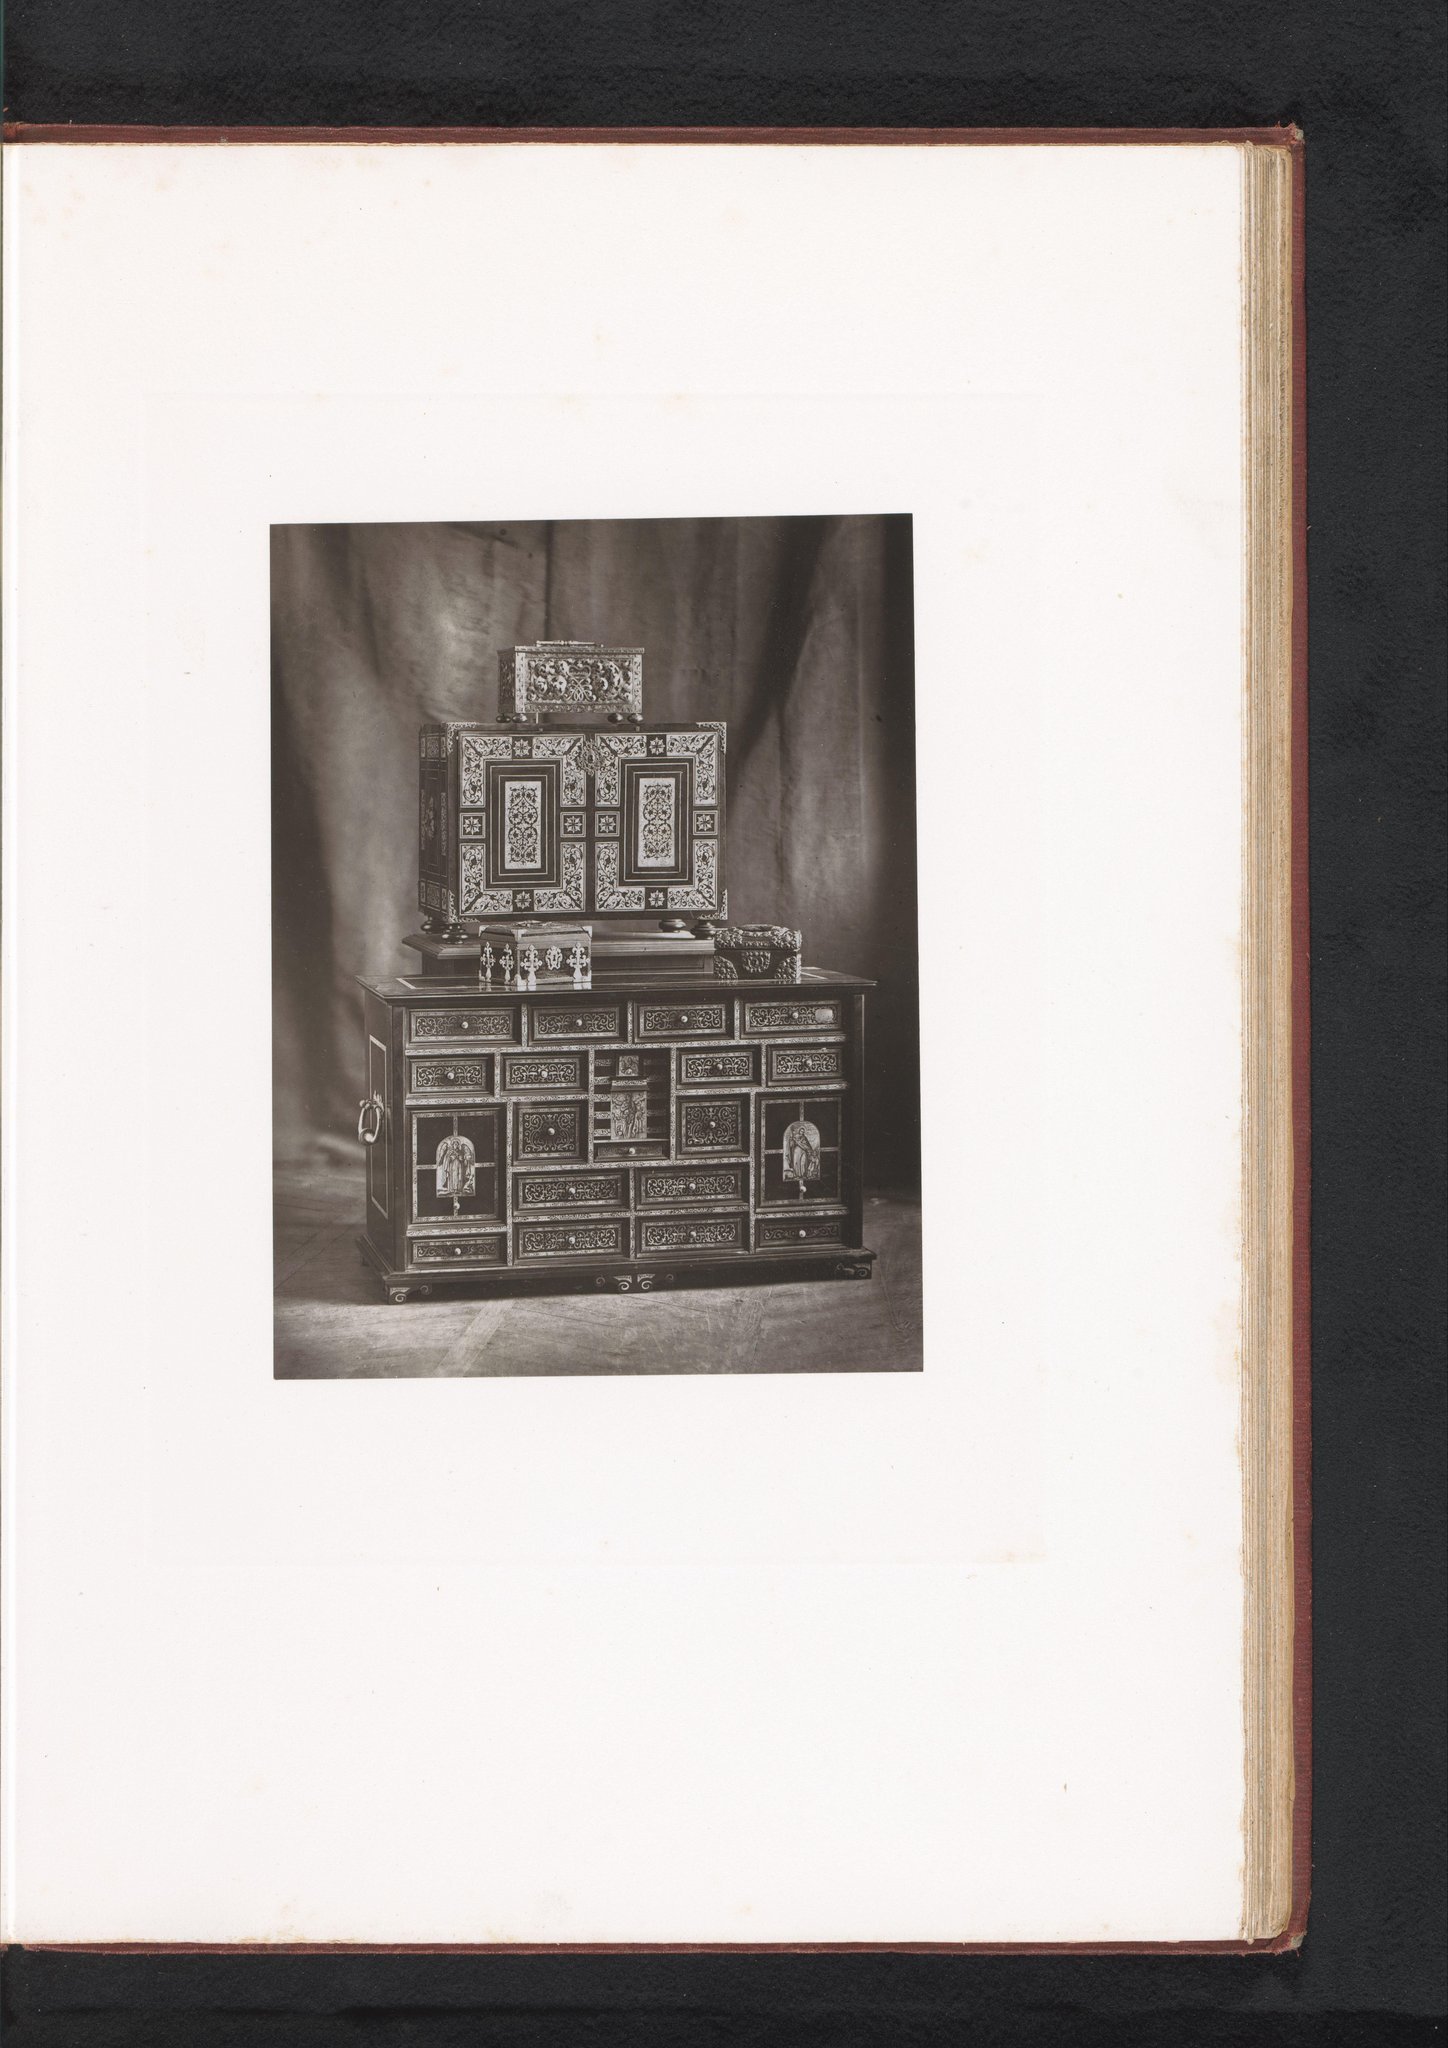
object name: photomechanical print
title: Twee kasten en drie kisten, opgesteld tijdens de Exposition Rétrospective van 1873 in Tours, Frankrijk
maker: gabriel blaise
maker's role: printer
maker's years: 1827-1897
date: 1873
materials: paper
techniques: woodburytype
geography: tours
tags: chest, coffer (+ wood and other phytogenic material), ornamental cupboard (+ wood and other phytogenic material), temporary exhibition, 'salon'